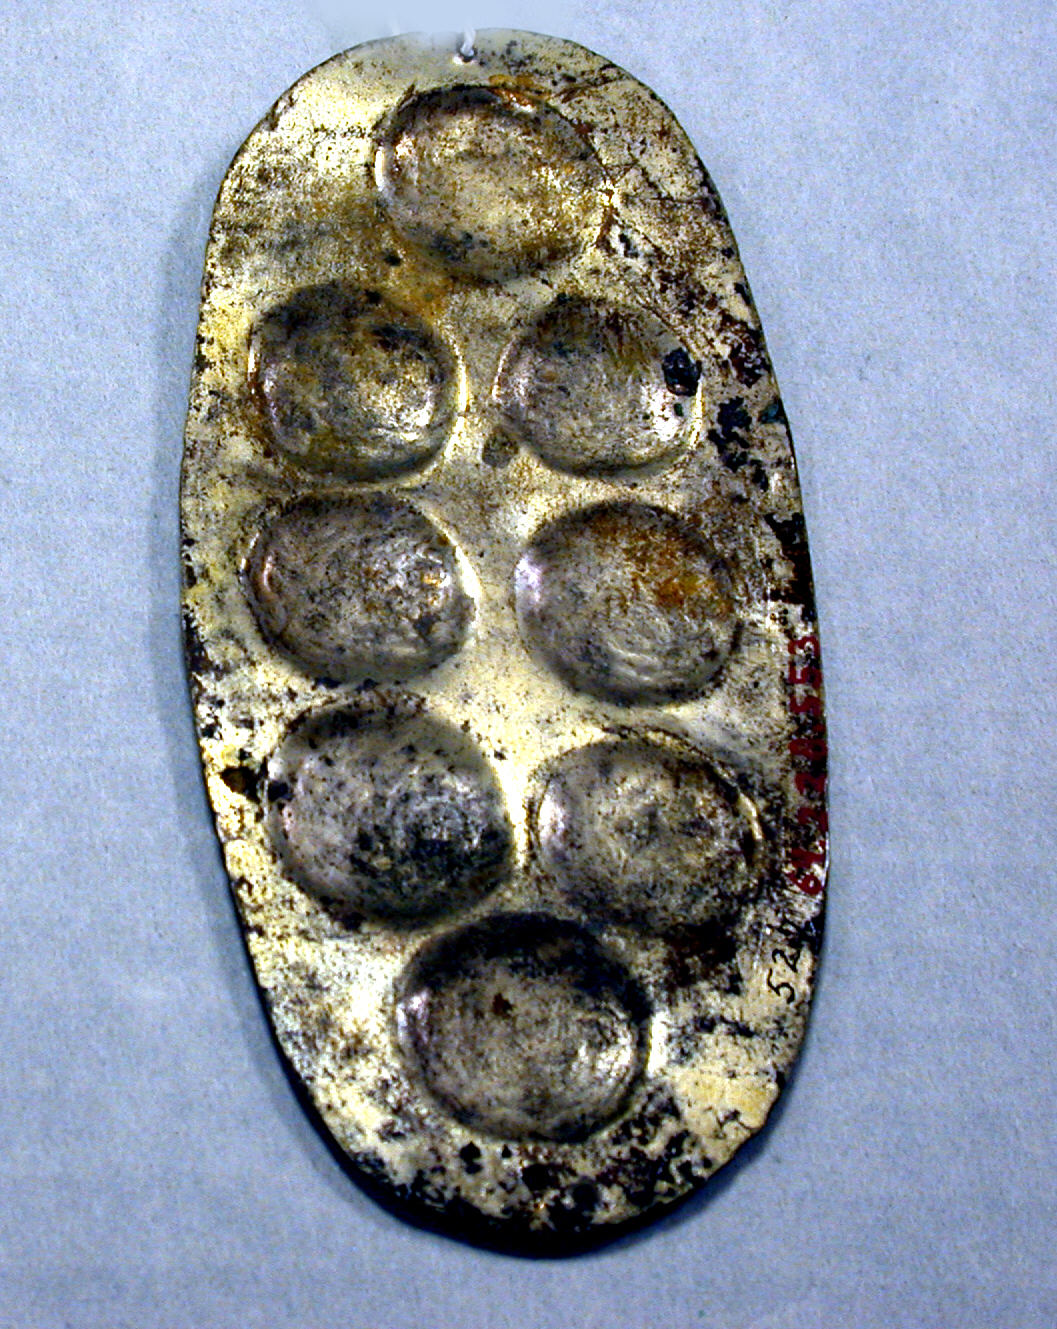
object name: ornament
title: Hammered Silver Ornament with Repoussé Disks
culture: peruvian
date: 701-1566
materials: gilt, silver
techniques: hammering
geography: peru